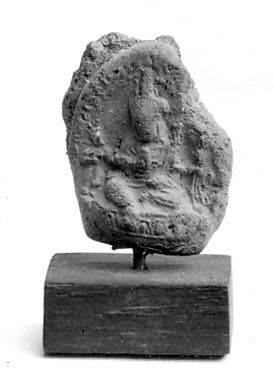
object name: plaque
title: Votive Plaque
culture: central asian or tibetan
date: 1401-1700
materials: clay